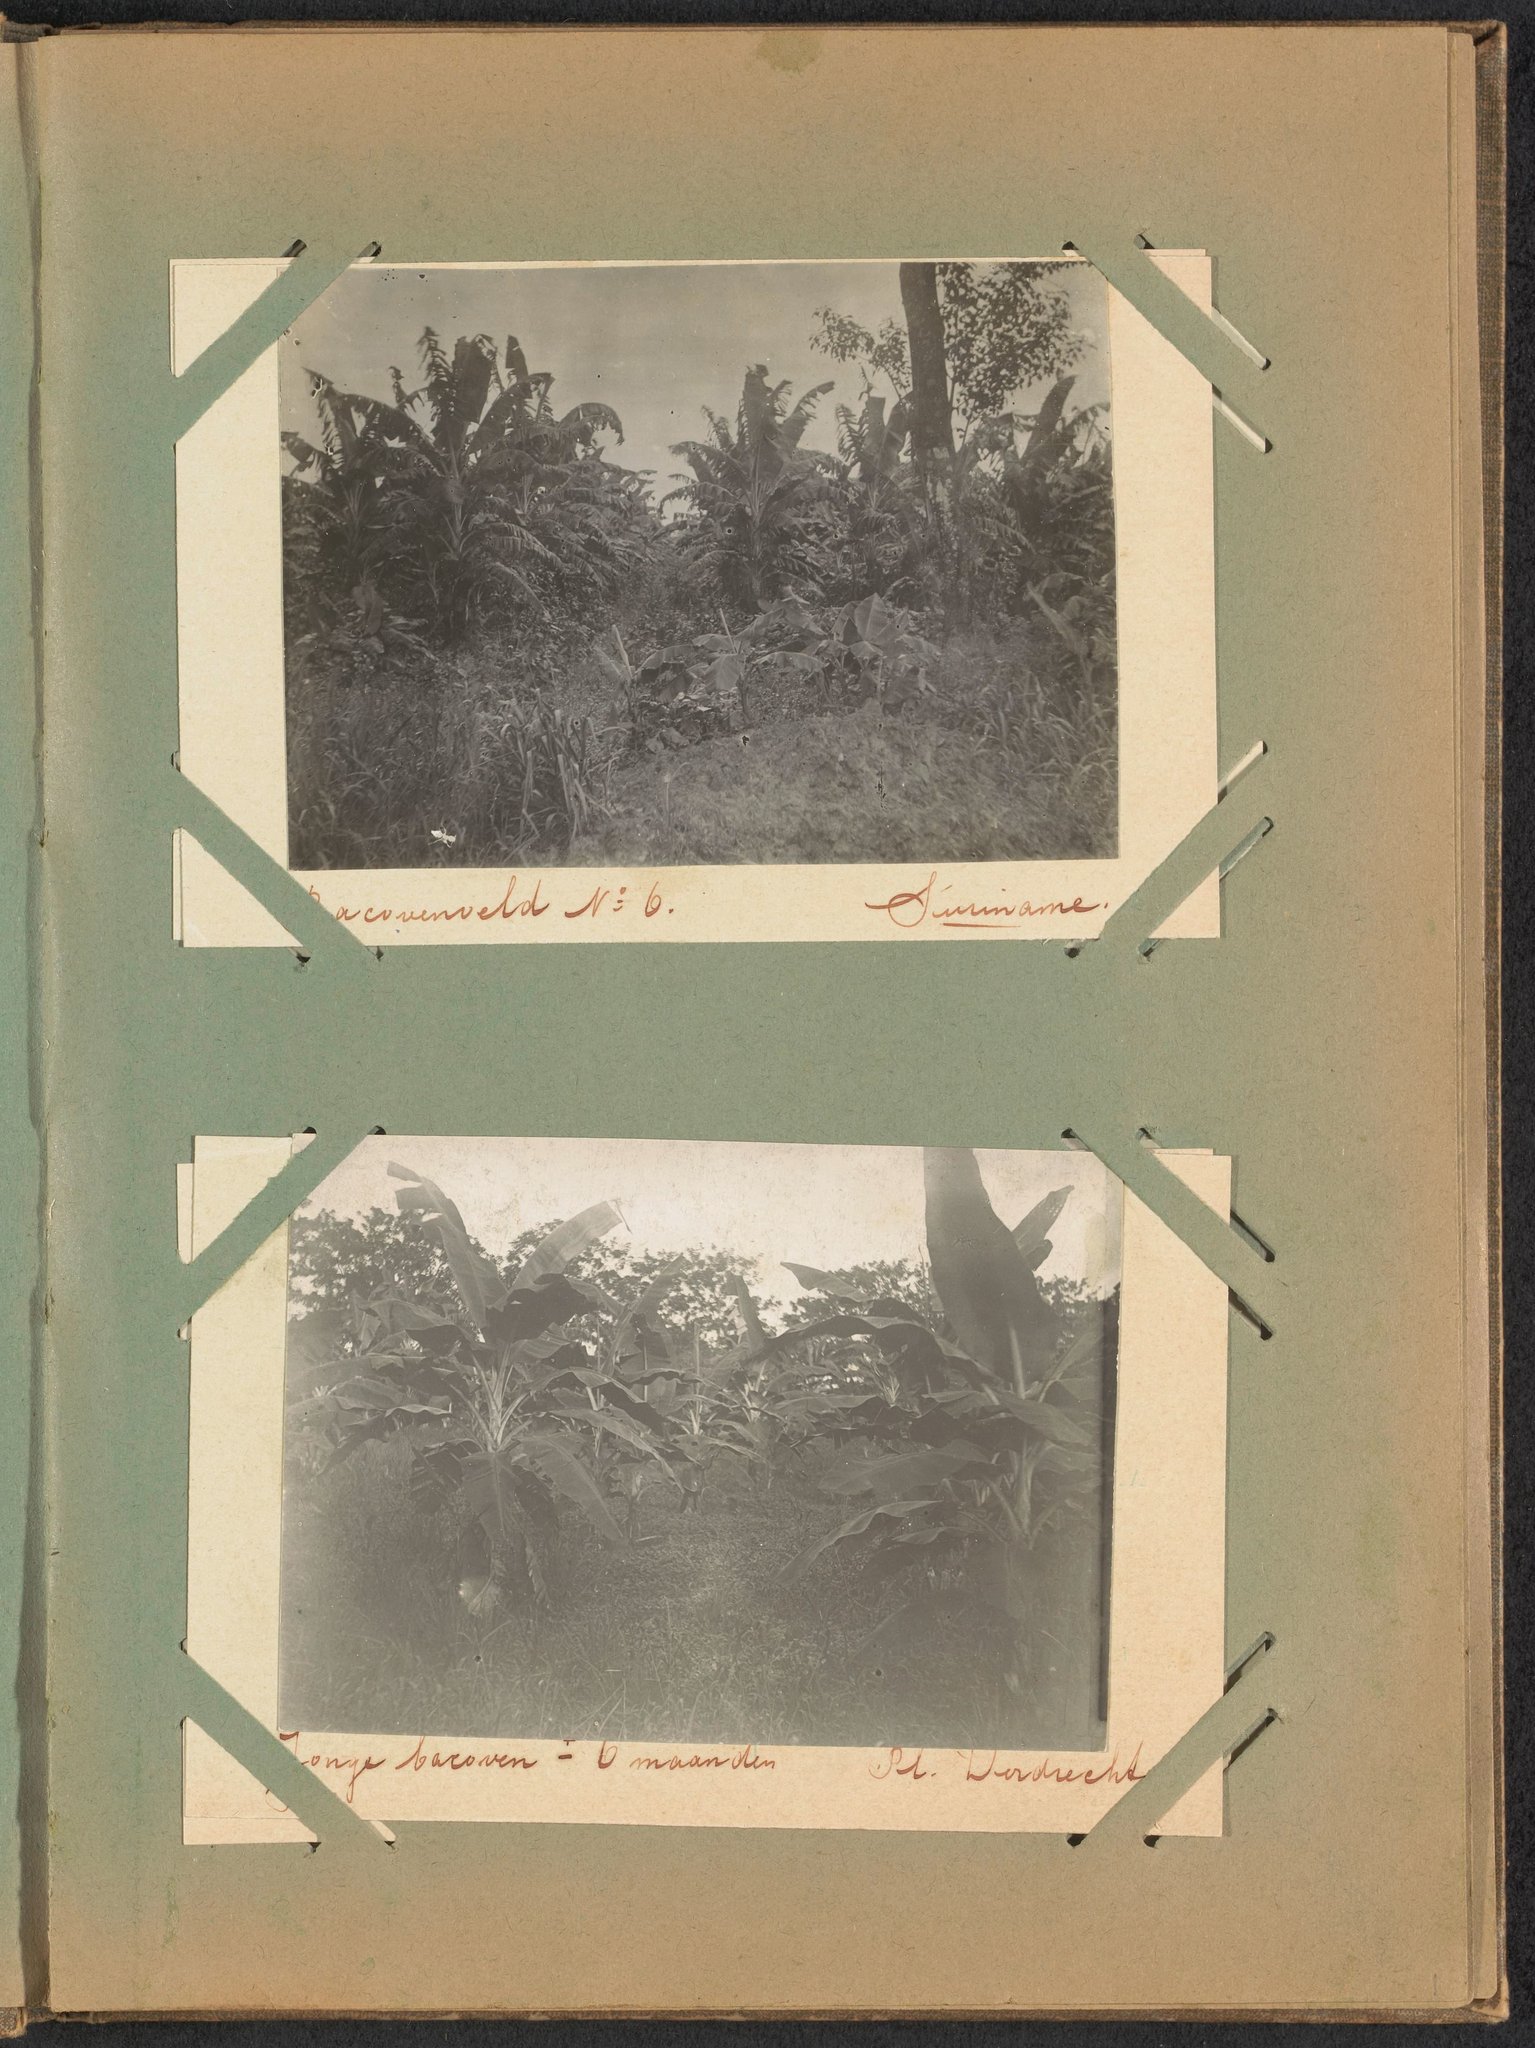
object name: photograph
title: Bananenbomen op Plantage Dordrecht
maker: Anonymous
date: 1912-1913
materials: paper, photographic support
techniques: gelatin silver print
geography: suriname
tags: plantation, fruits: banana, suriname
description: Bananenbomen op Plantage Dordrecht in Suriname. Onderdeel van het fotoalbum uit ca. 1912-1913 met 92 foto's van de plantages Peperpot en Dordrecht in Suriname en Mount Pleasant op Curaçao.